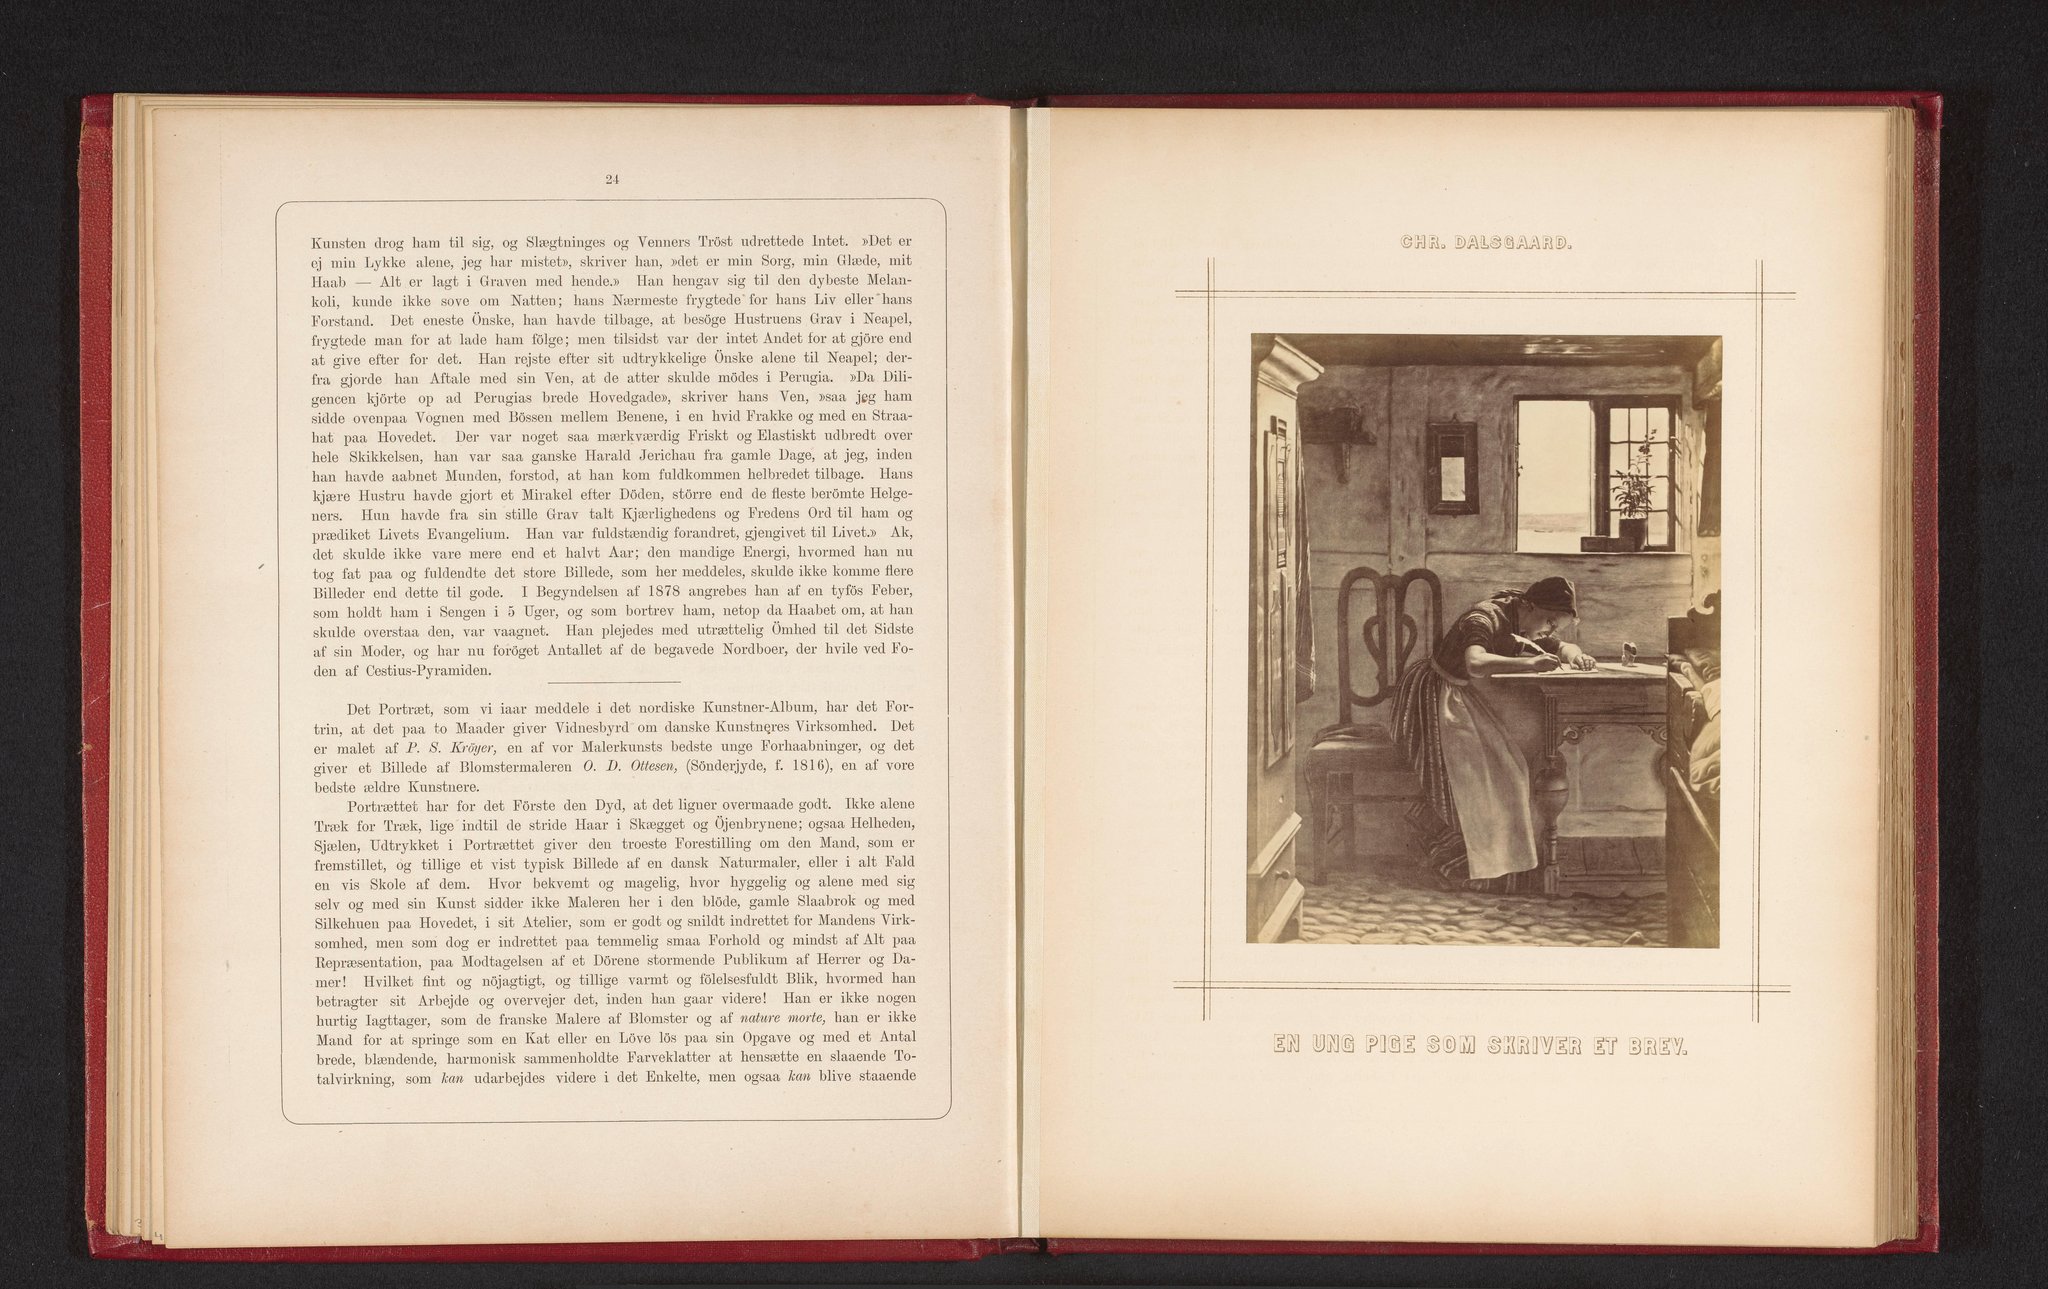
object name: page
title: En Ung Pige Som Skriver Et Brev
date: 1874-1879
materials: photographic support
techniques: albumen print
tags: handwriting, writing as activity, adult woman